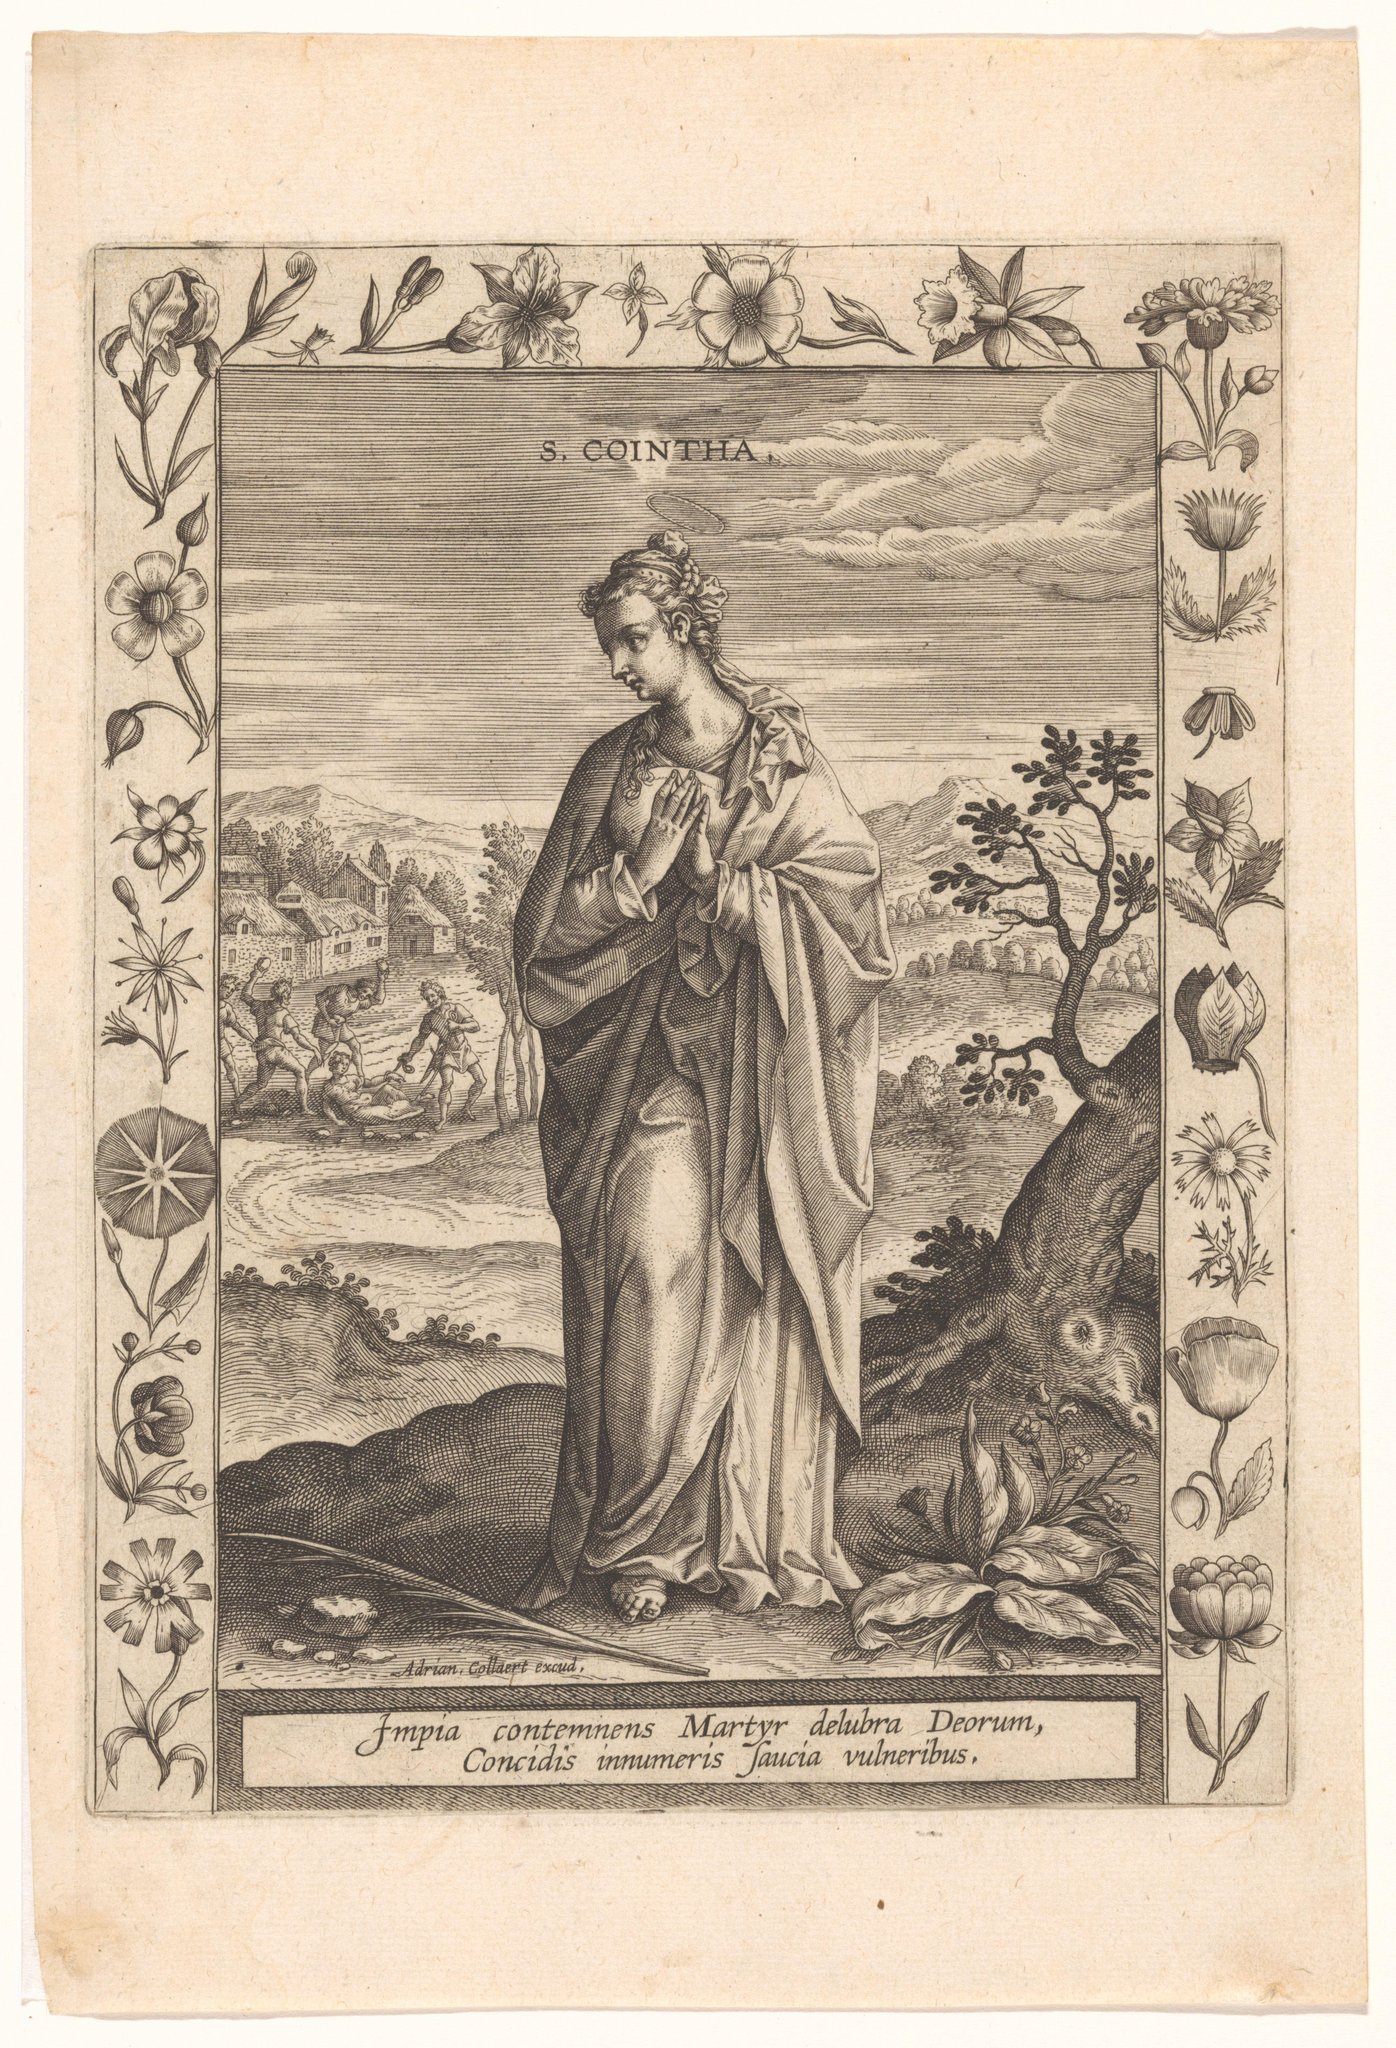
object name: print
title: Heilige Cointha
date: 1590-1610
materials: paper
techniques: engraving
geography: antwerp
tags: flowers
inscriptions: collector's mark: Lugt 2228, collector's mark: Lugt 3751, collector's mark: Lugt 2760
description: Heilige Cointha. Onderdeel van een serie van 24 voorstellingen van vrouwelijke martelaren (martyrologium). De voorstellingen zijn voorzien van randen met bloemen en dieren.